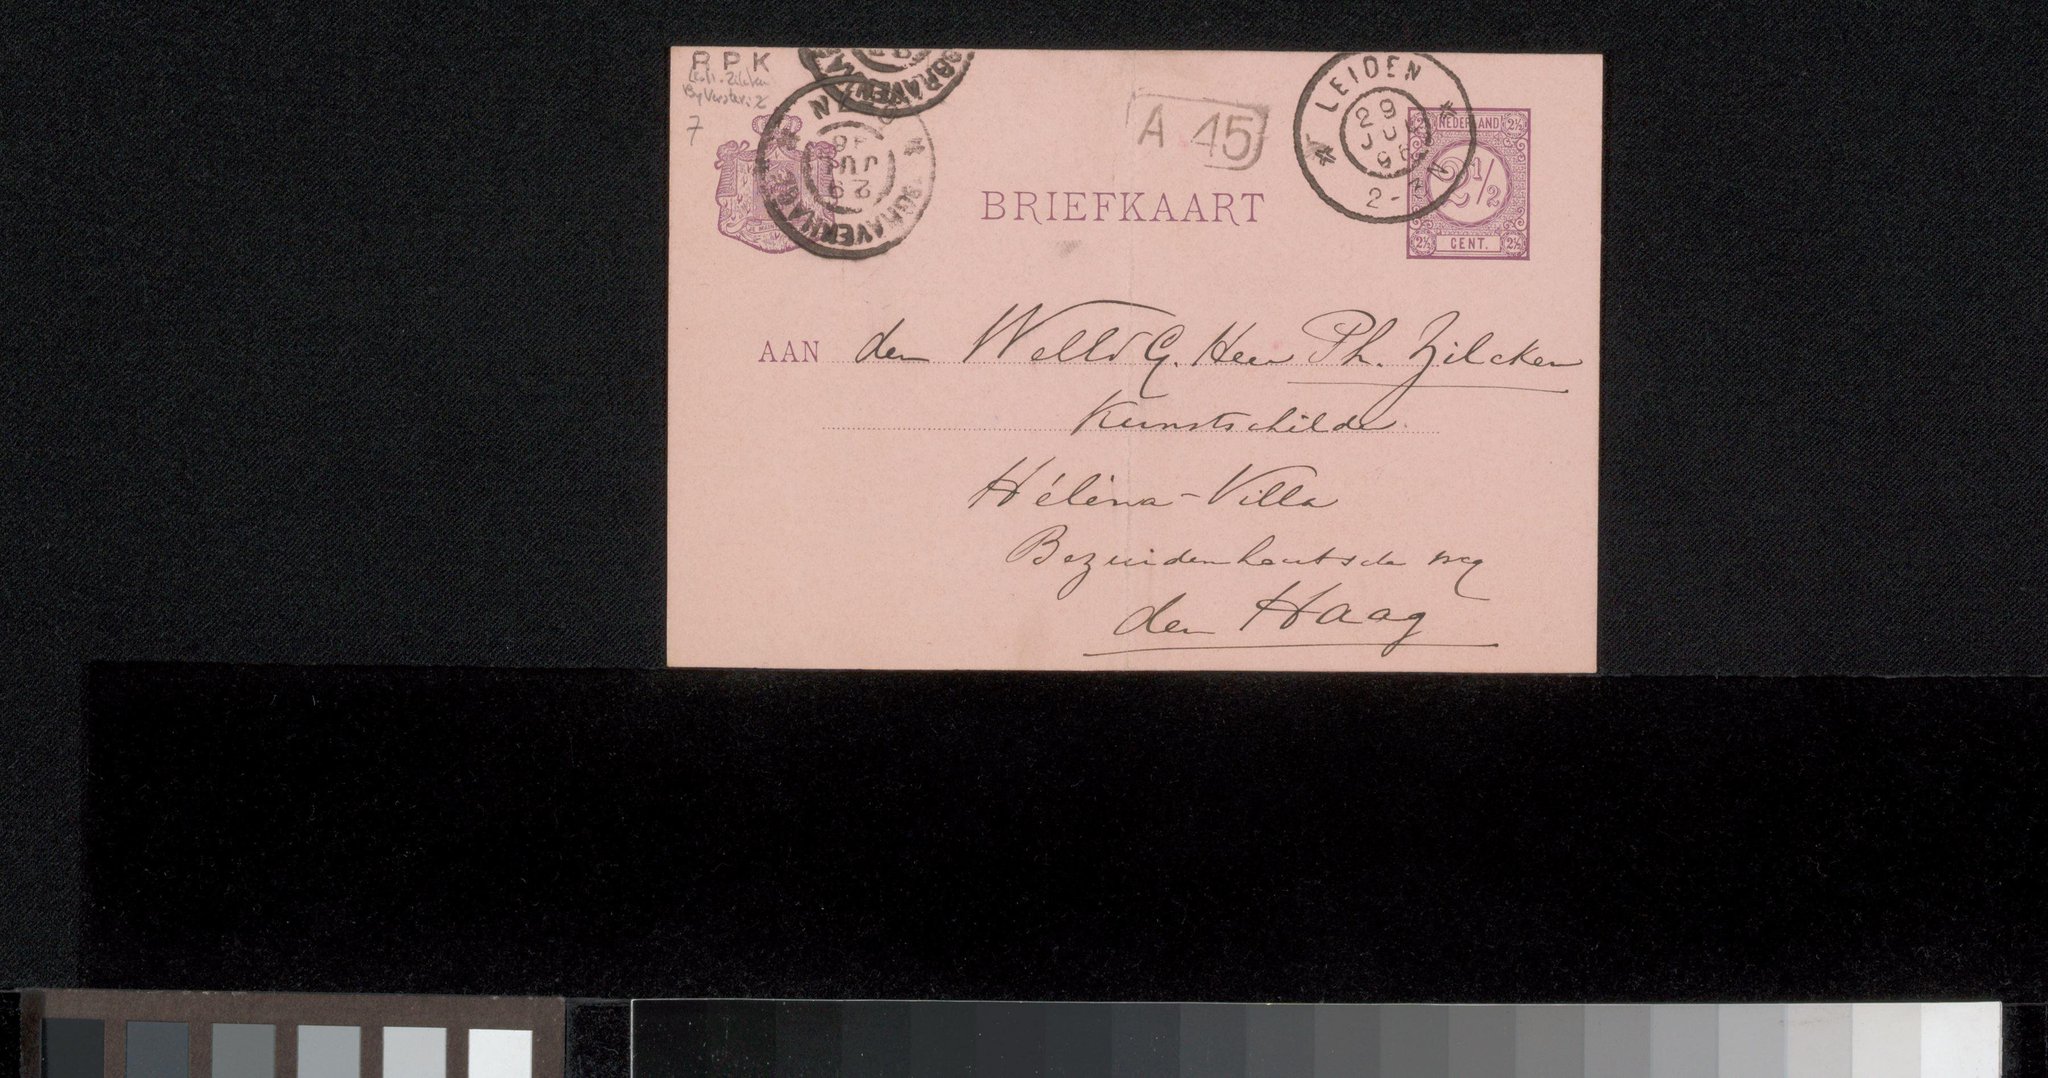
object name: postcard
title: Briefkaart aan Philip Zilcken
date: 1896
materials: cardboard, ink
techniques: pen, writing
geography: leiden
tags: alexander hugo bakker korff, henricus maria antonius coebergh, the hague, painter, draughtsman, philip zilcken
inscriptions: collector's mark: ‘RPK’